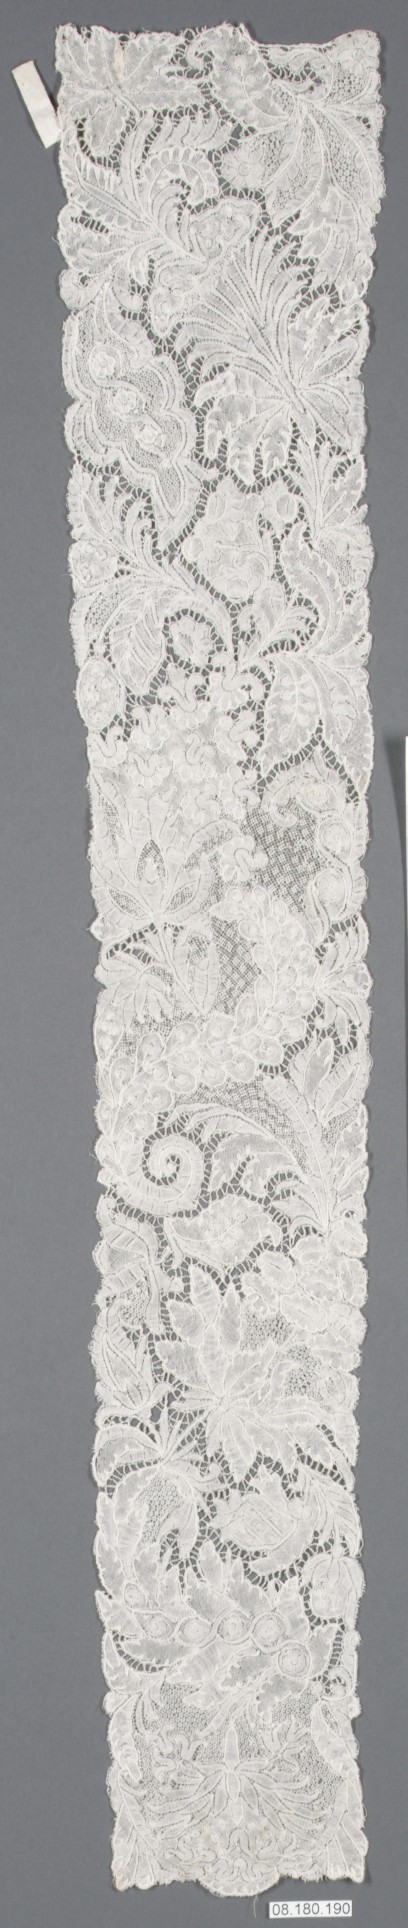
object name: barbe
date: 1701-1800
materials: lace